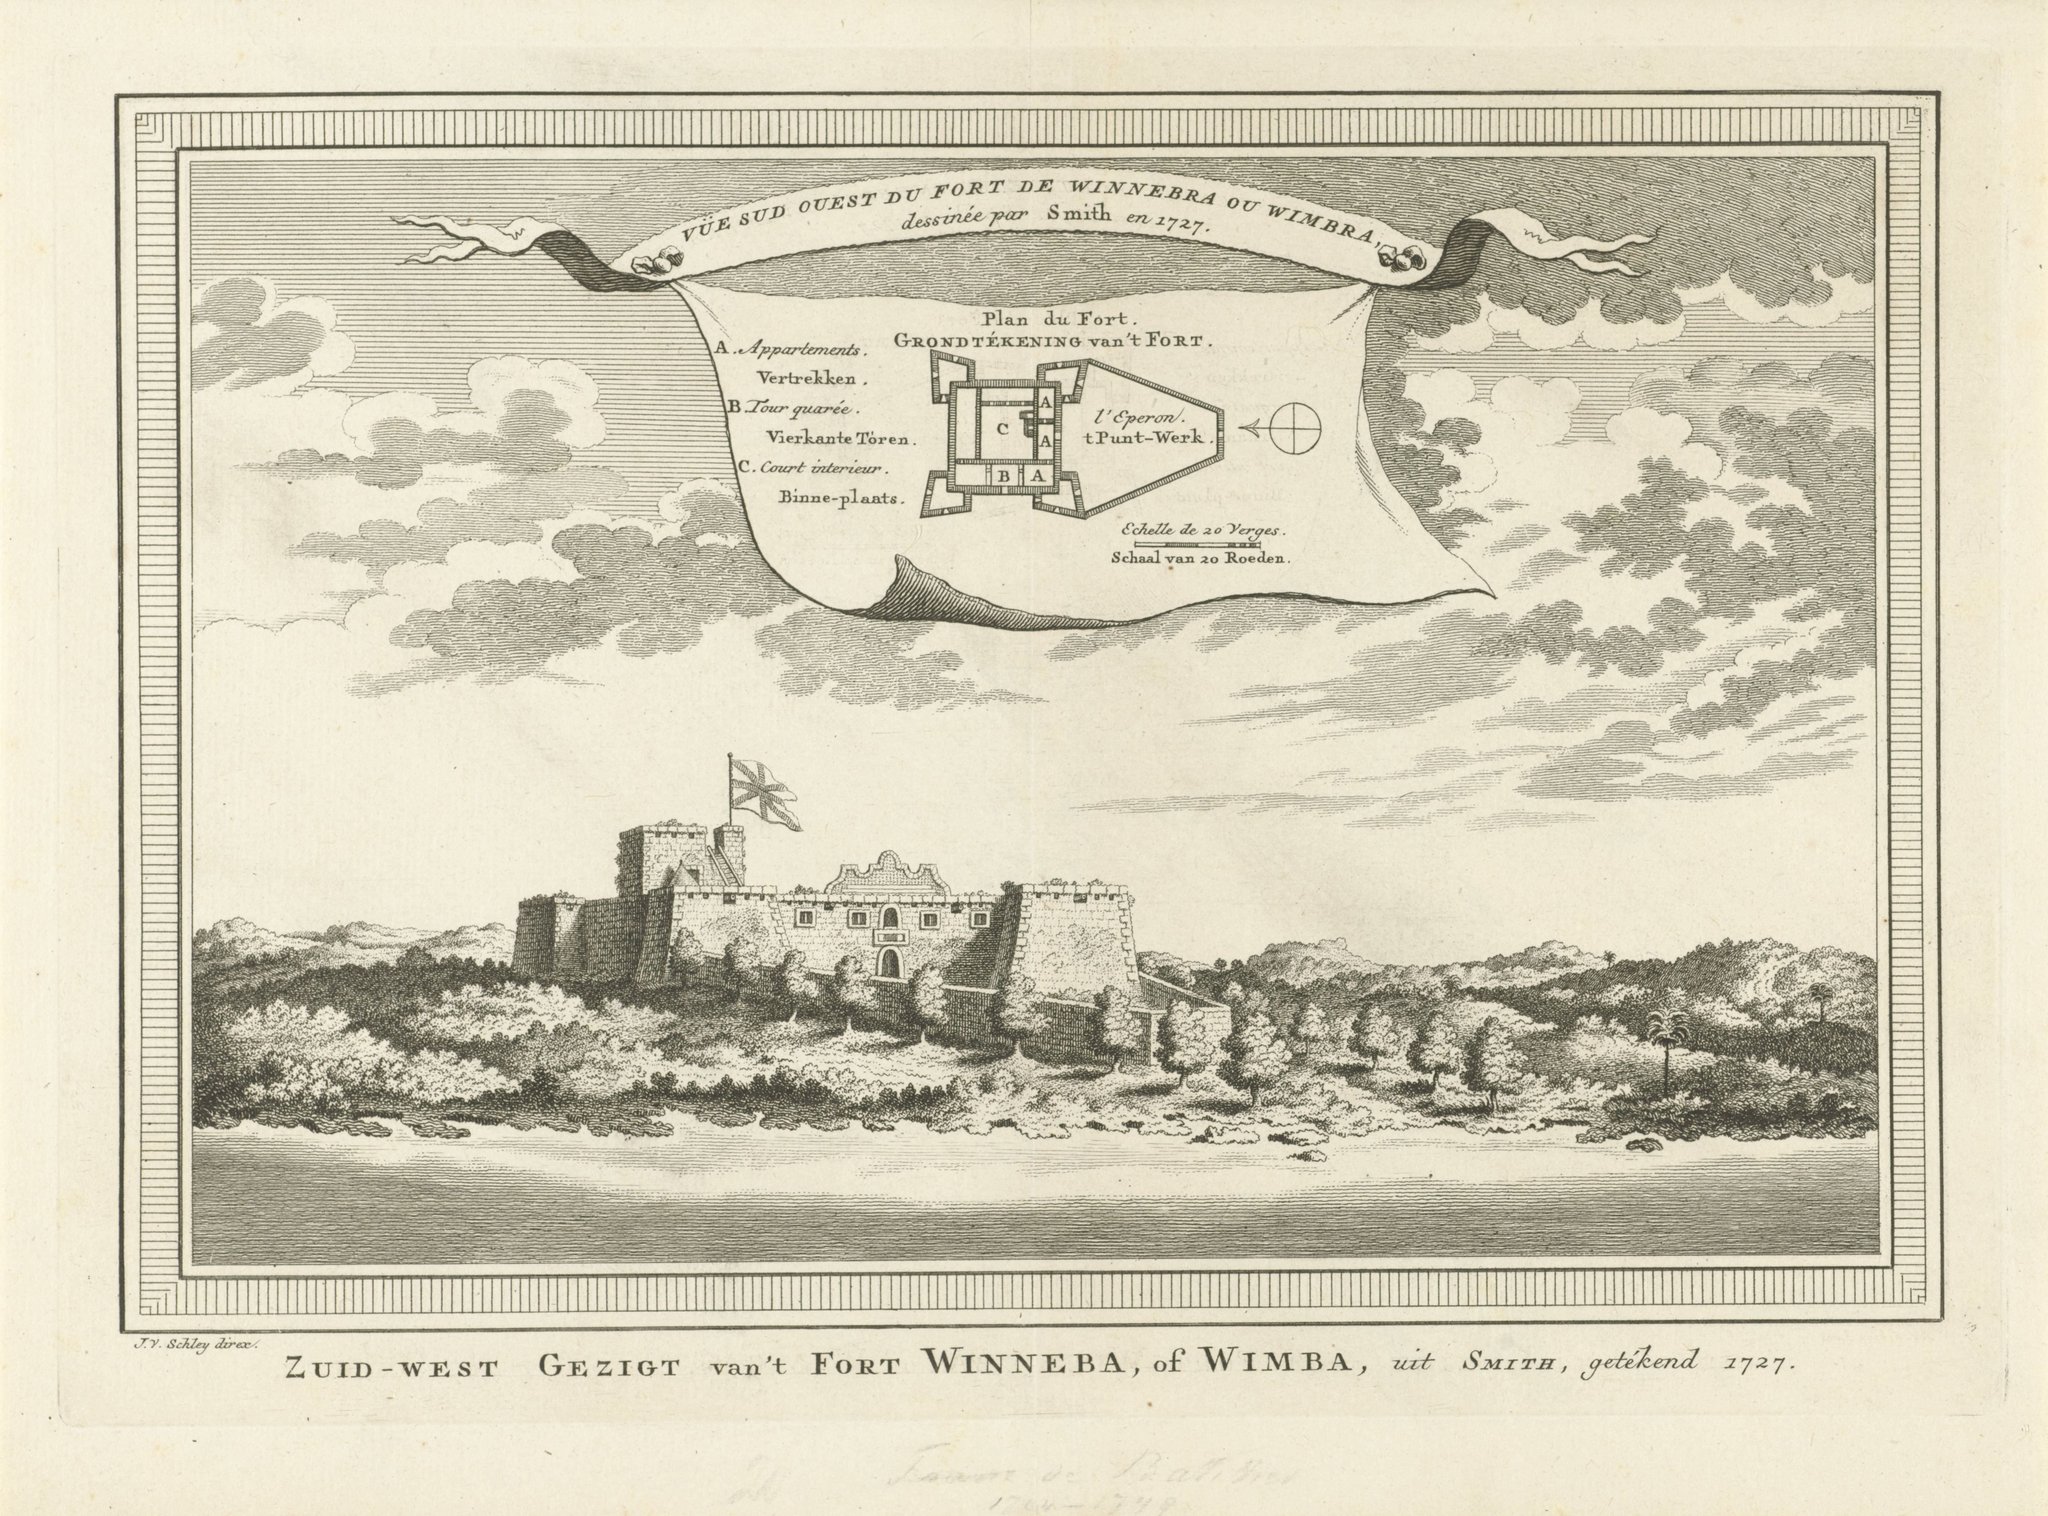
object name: print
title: Südliche Aussicht des Forts Dickse aus Smithen, Z.W. Gezigt van 't Fort Winneka; Sudwestliche Aussicht von Williams Fort; Chinesisches Leichenbegaengniss; Sudw. Aussicht des Englischen und holl. Fort zu Sukkondi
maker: jacob van der schley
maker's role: draughtsman, print maker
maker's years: 1715-1779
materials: paper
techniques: etching